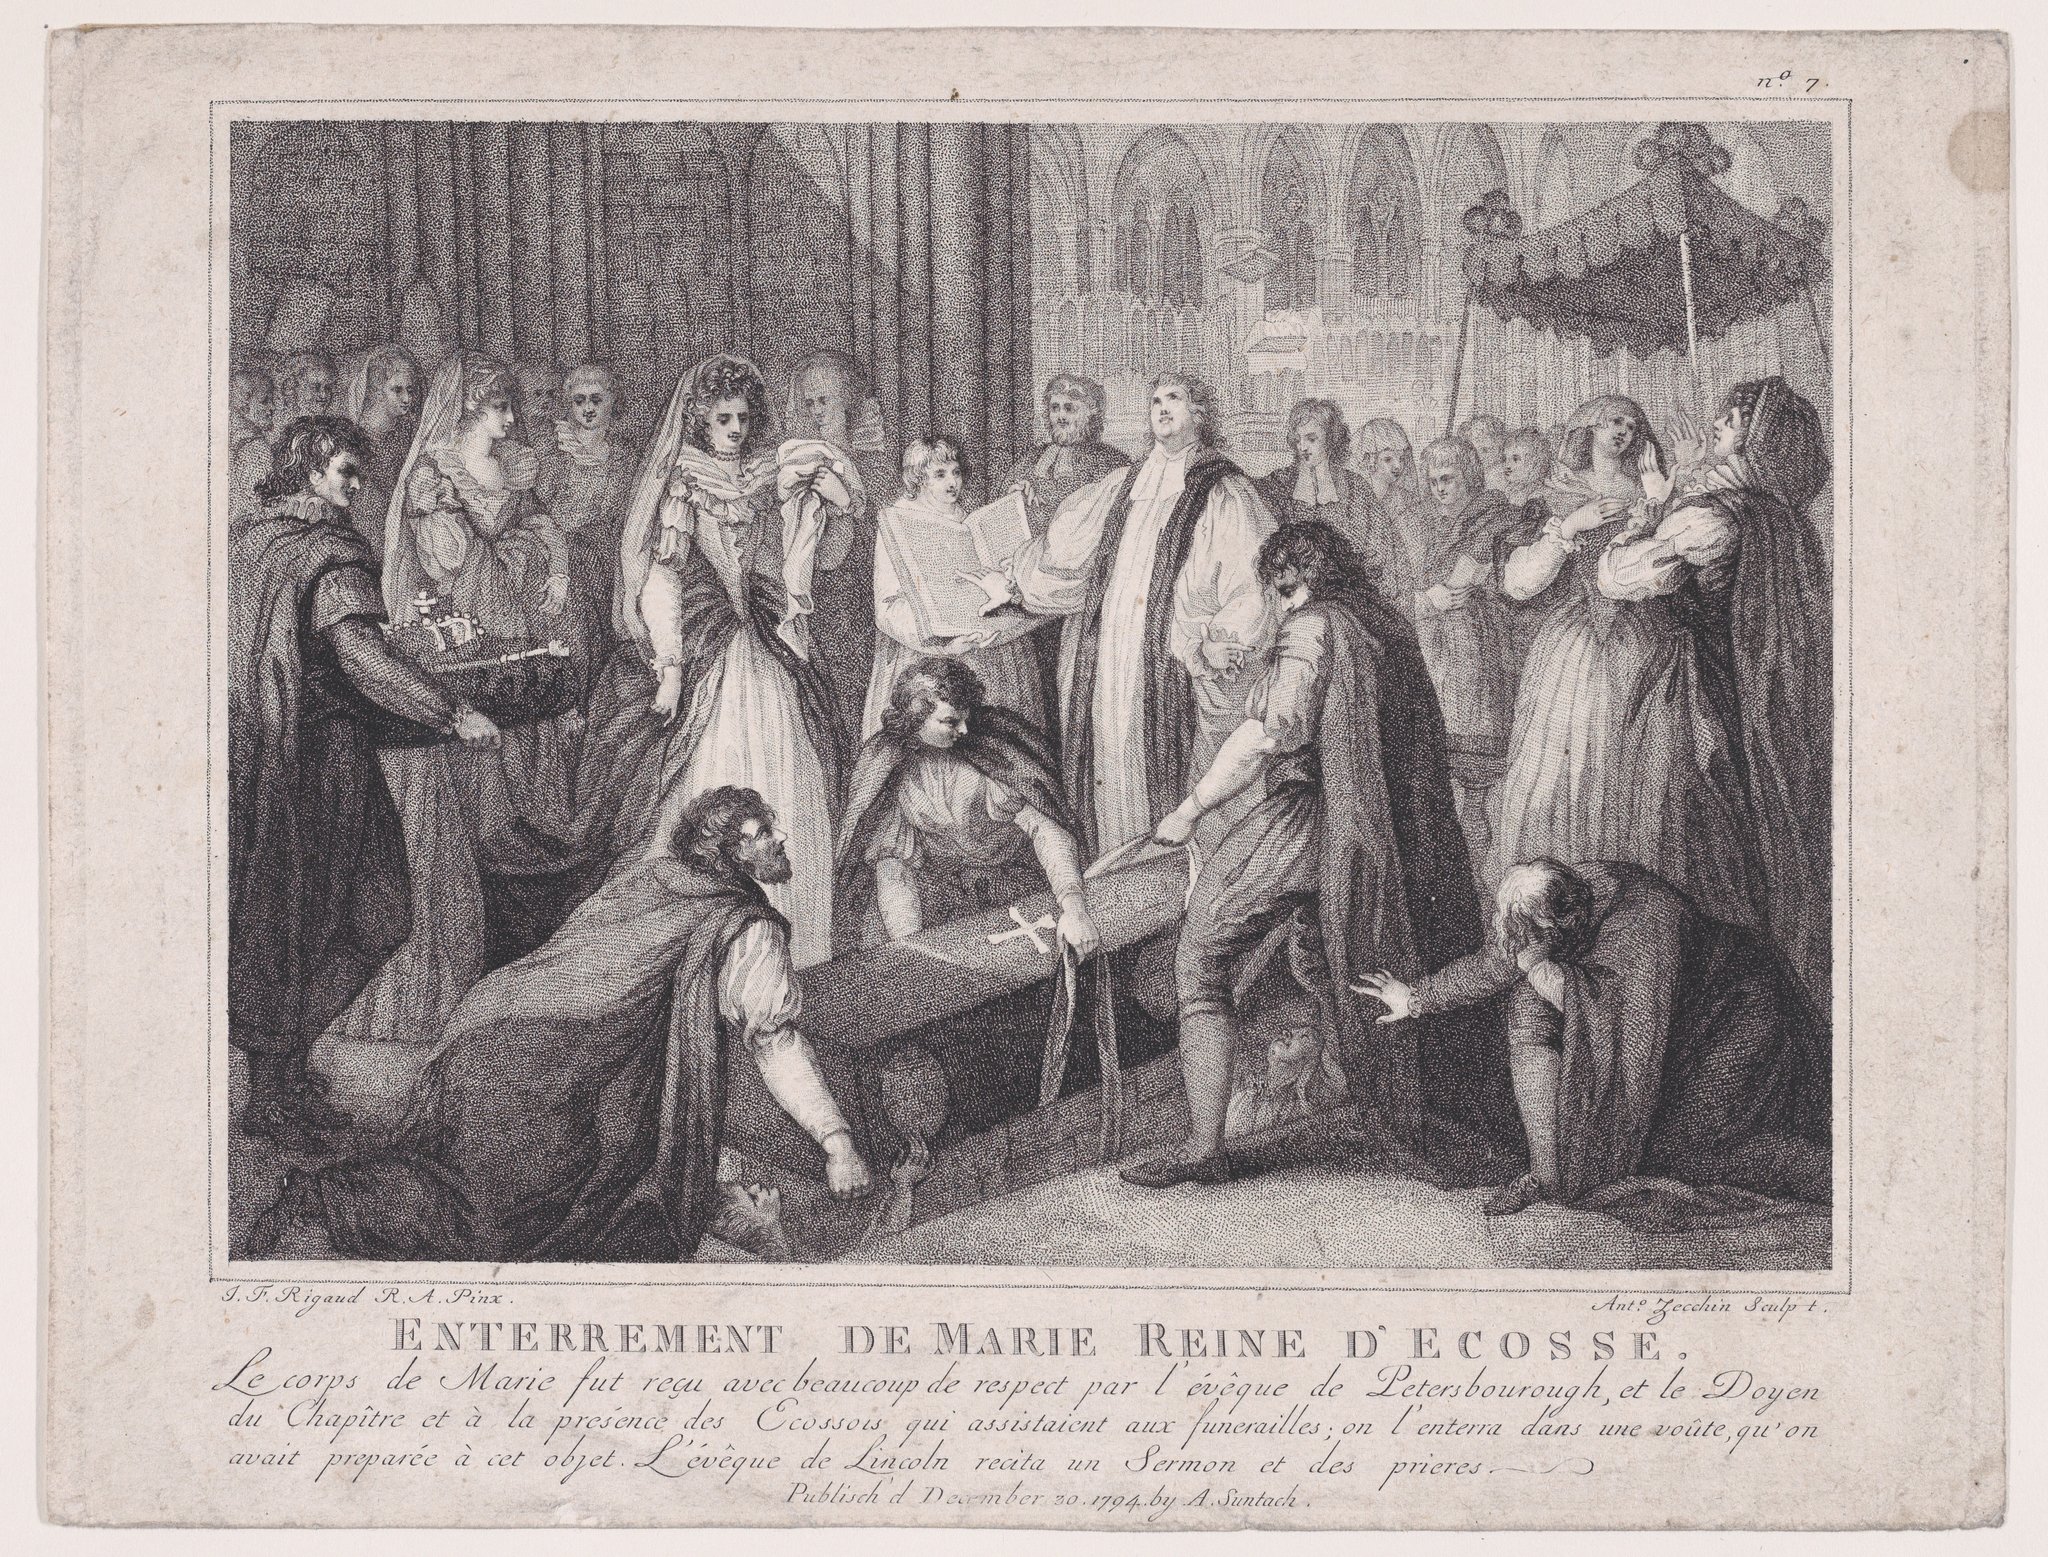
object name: print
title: The Internment of Mary, Queen of Scots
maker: antonio zecchin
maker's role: artist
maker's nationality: italian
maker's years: 1780-1880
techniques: engraving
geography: england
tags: men,women,burials,mary queen of scots